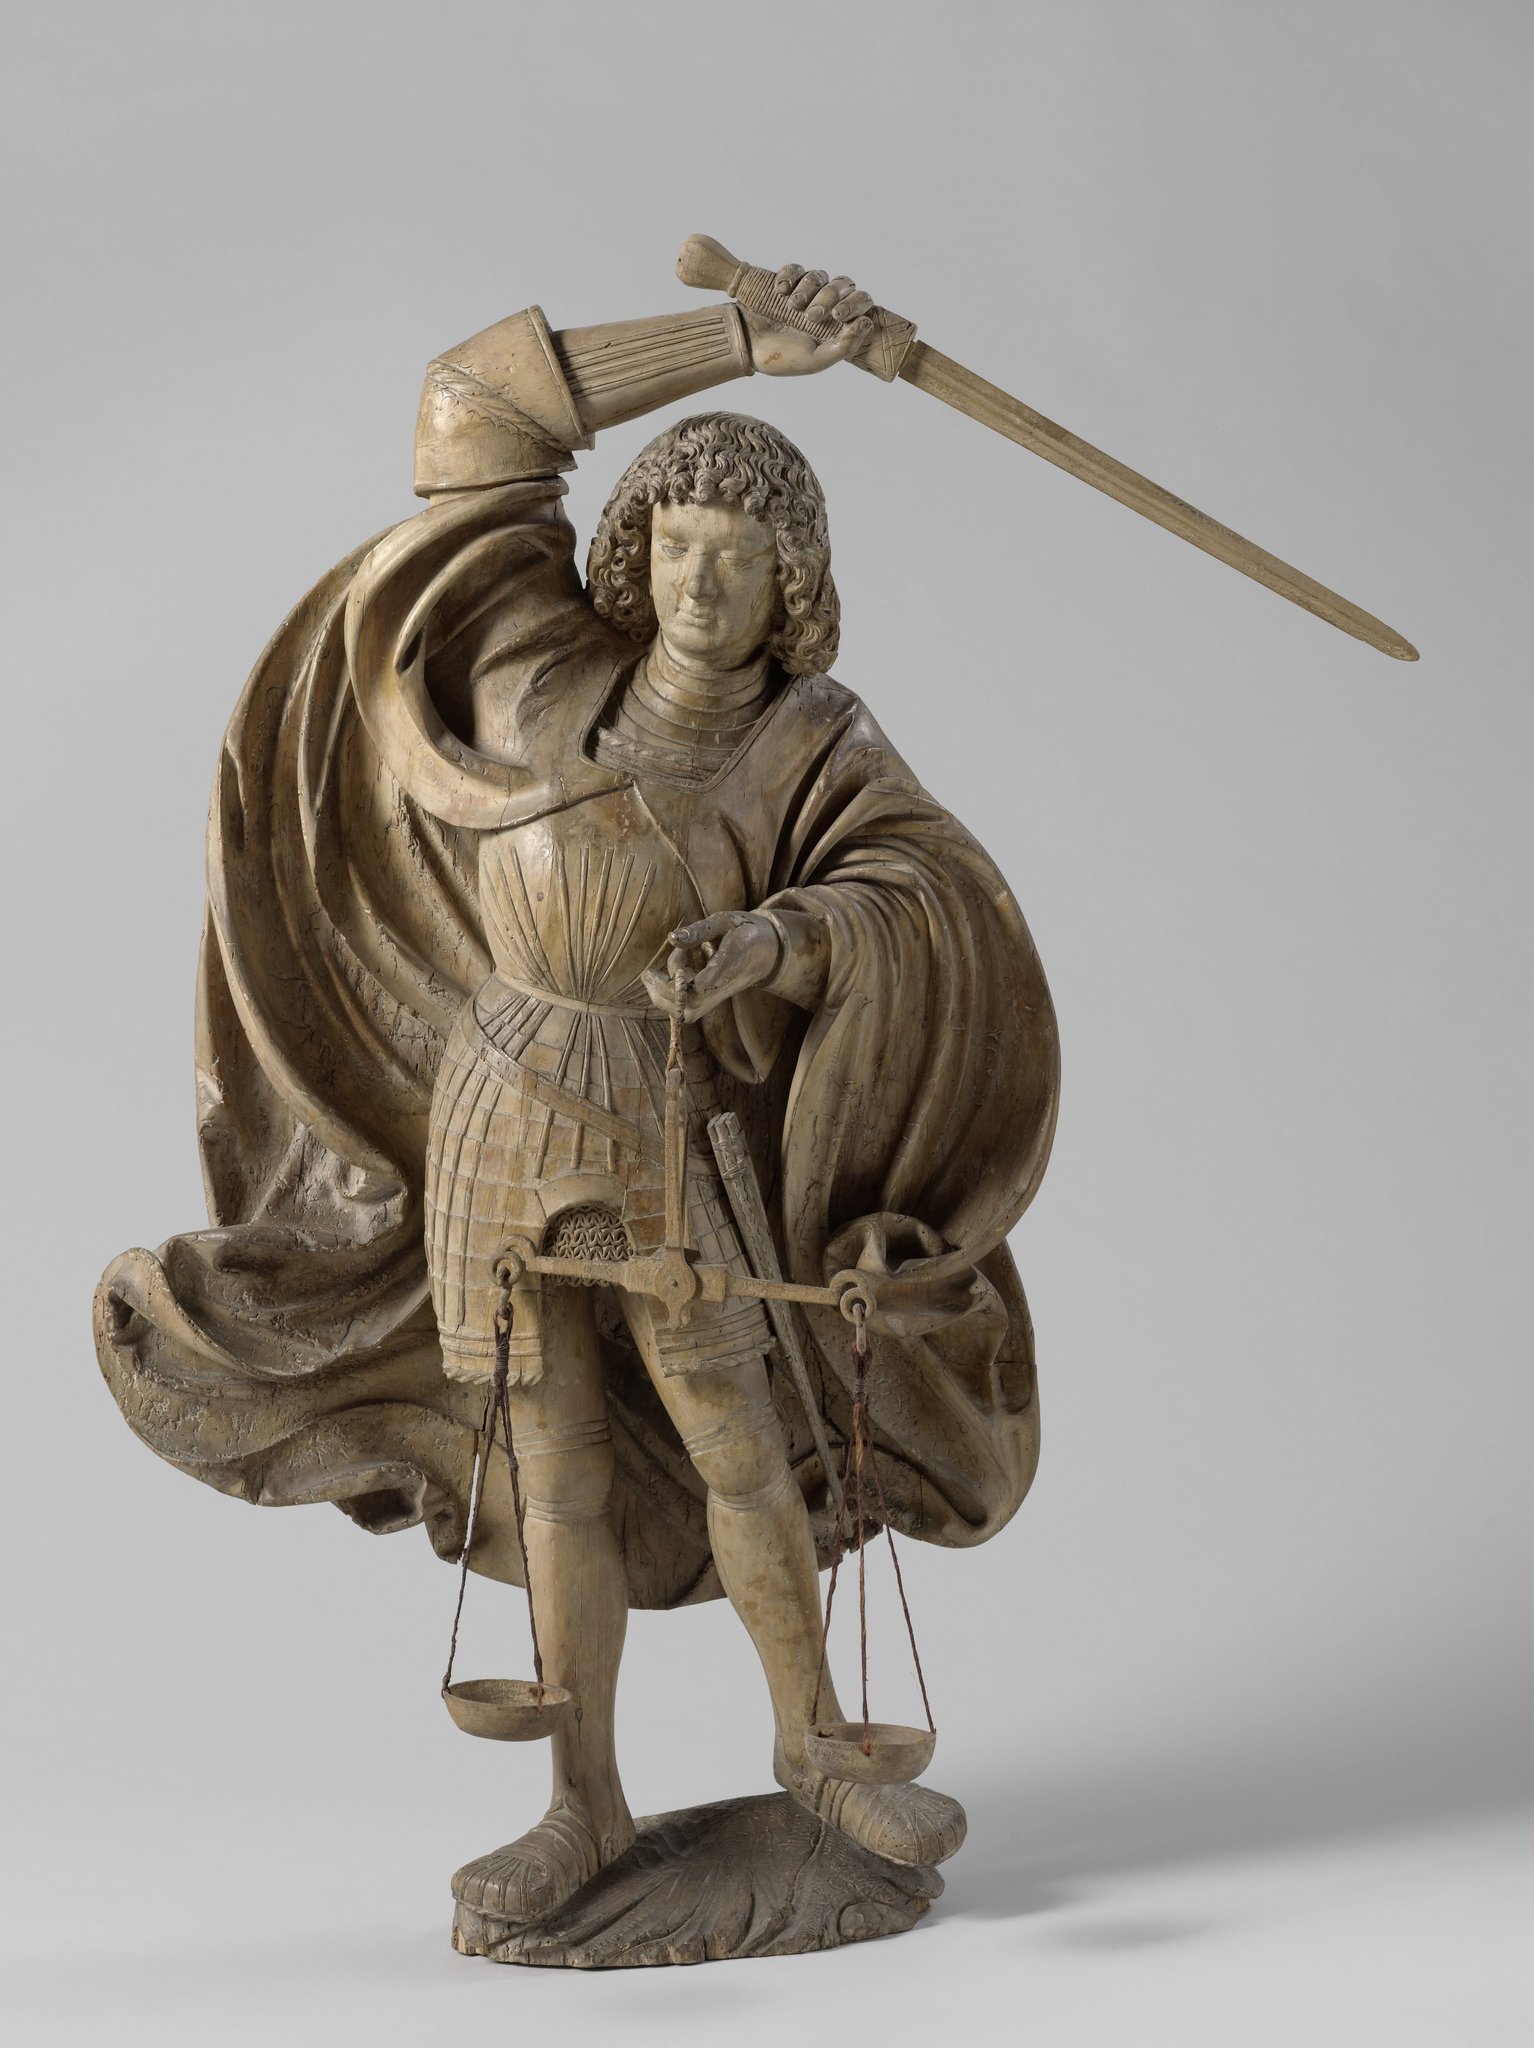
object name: sculpture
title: Aartsengel Michaël als zielenweger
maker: meester van ottobeuren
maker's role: sculptor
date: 1510-1520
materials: wood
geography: tirol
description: The Archangel Michael Weighing Souls. Limewood, originally with polychromy Tyrol, c. 1510 - 1520.